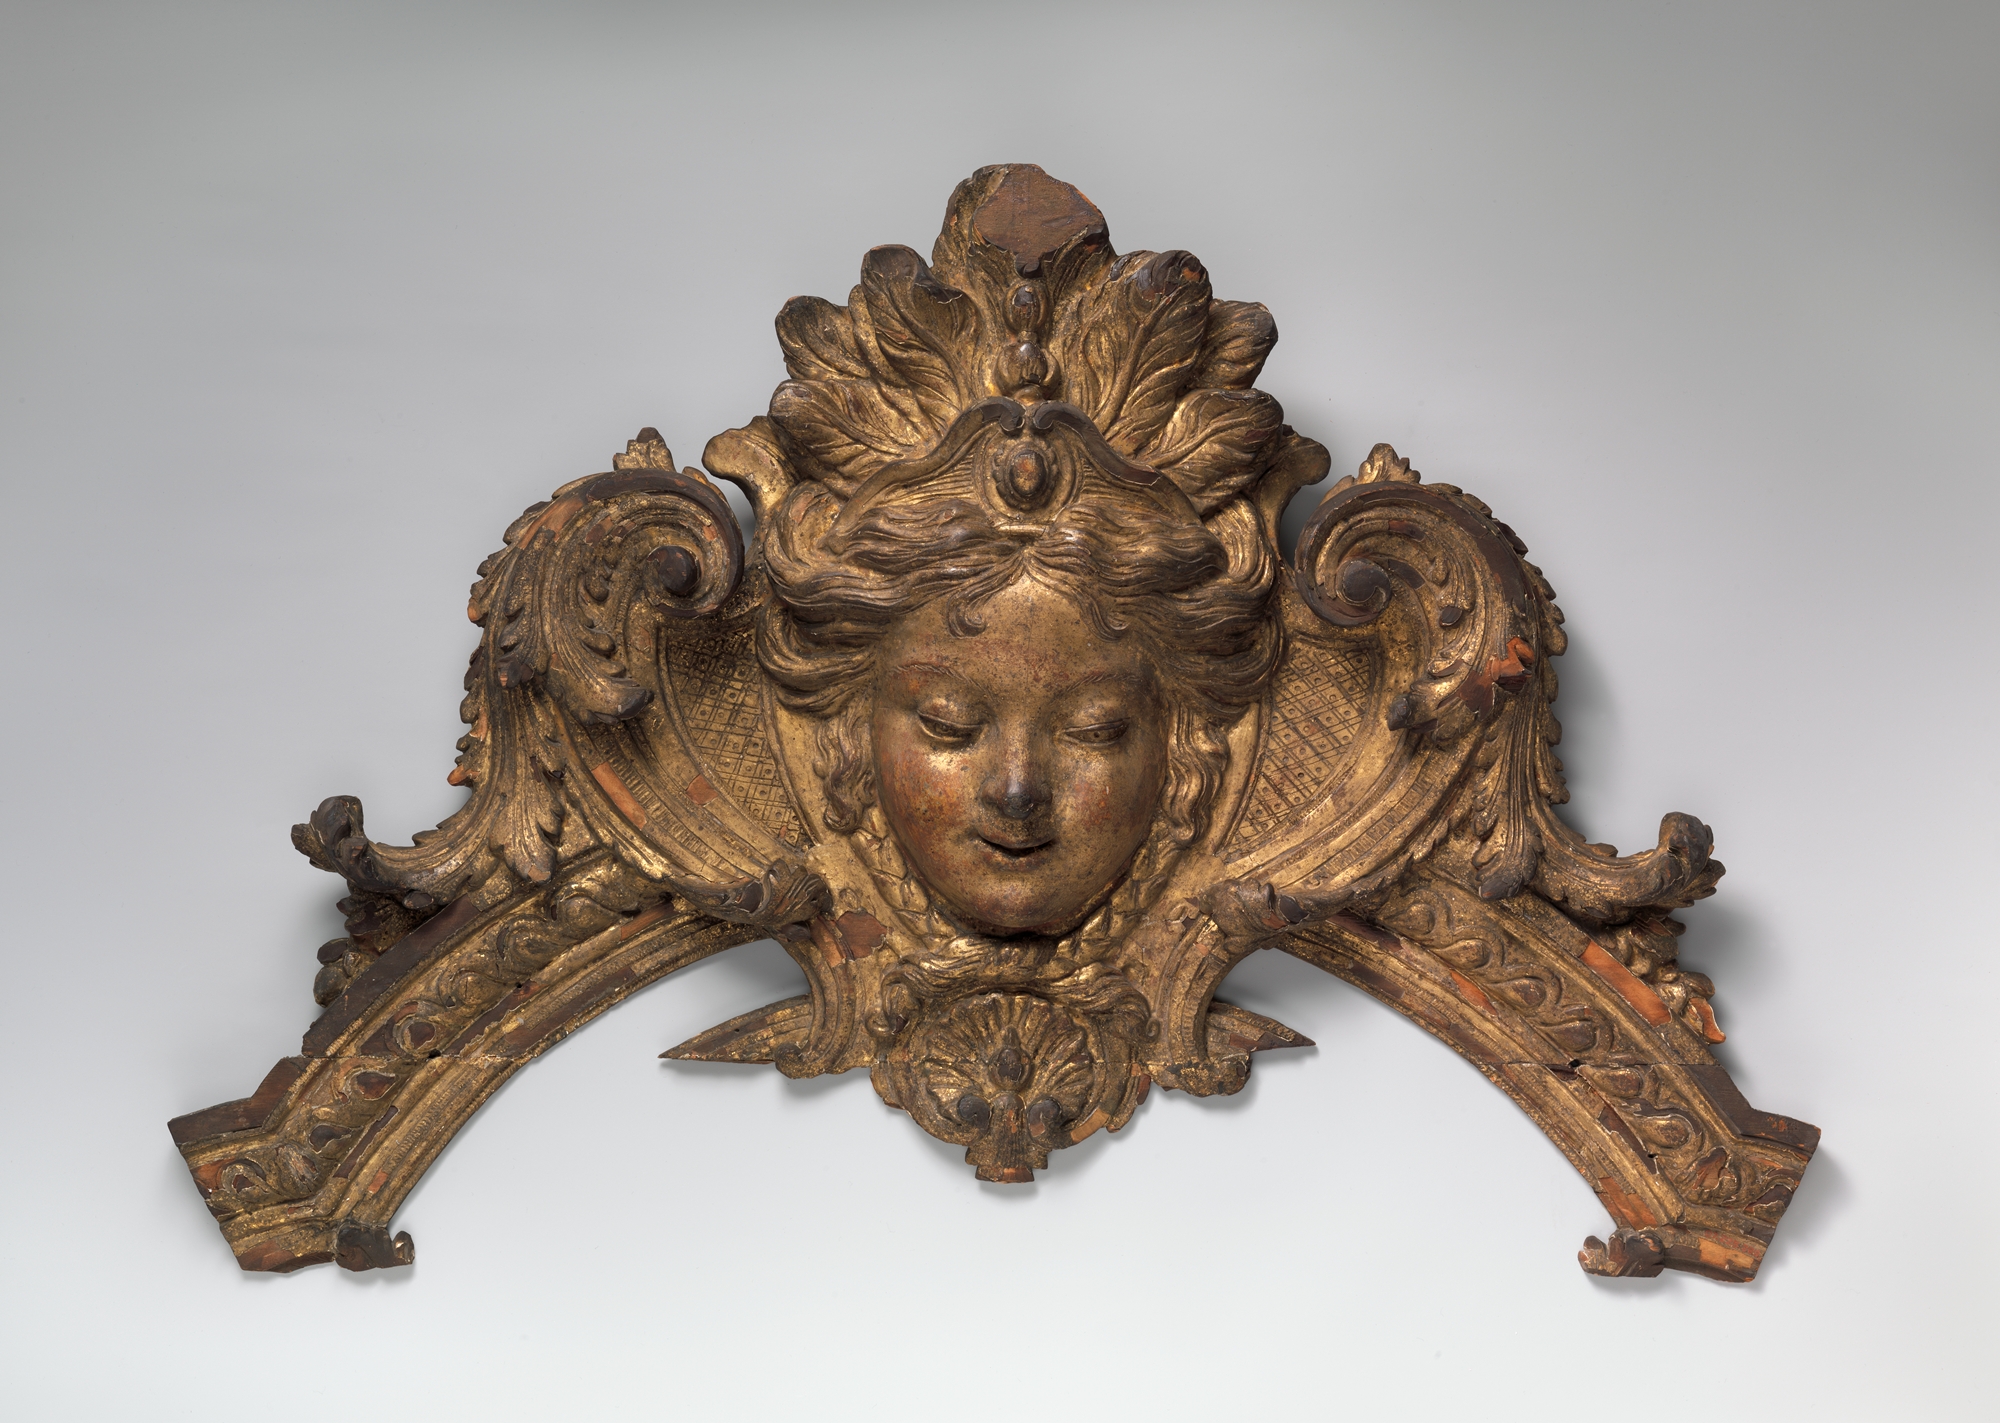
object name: mirror frame fragment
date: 1701-1800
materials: wood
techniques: carving, gilding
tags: faces